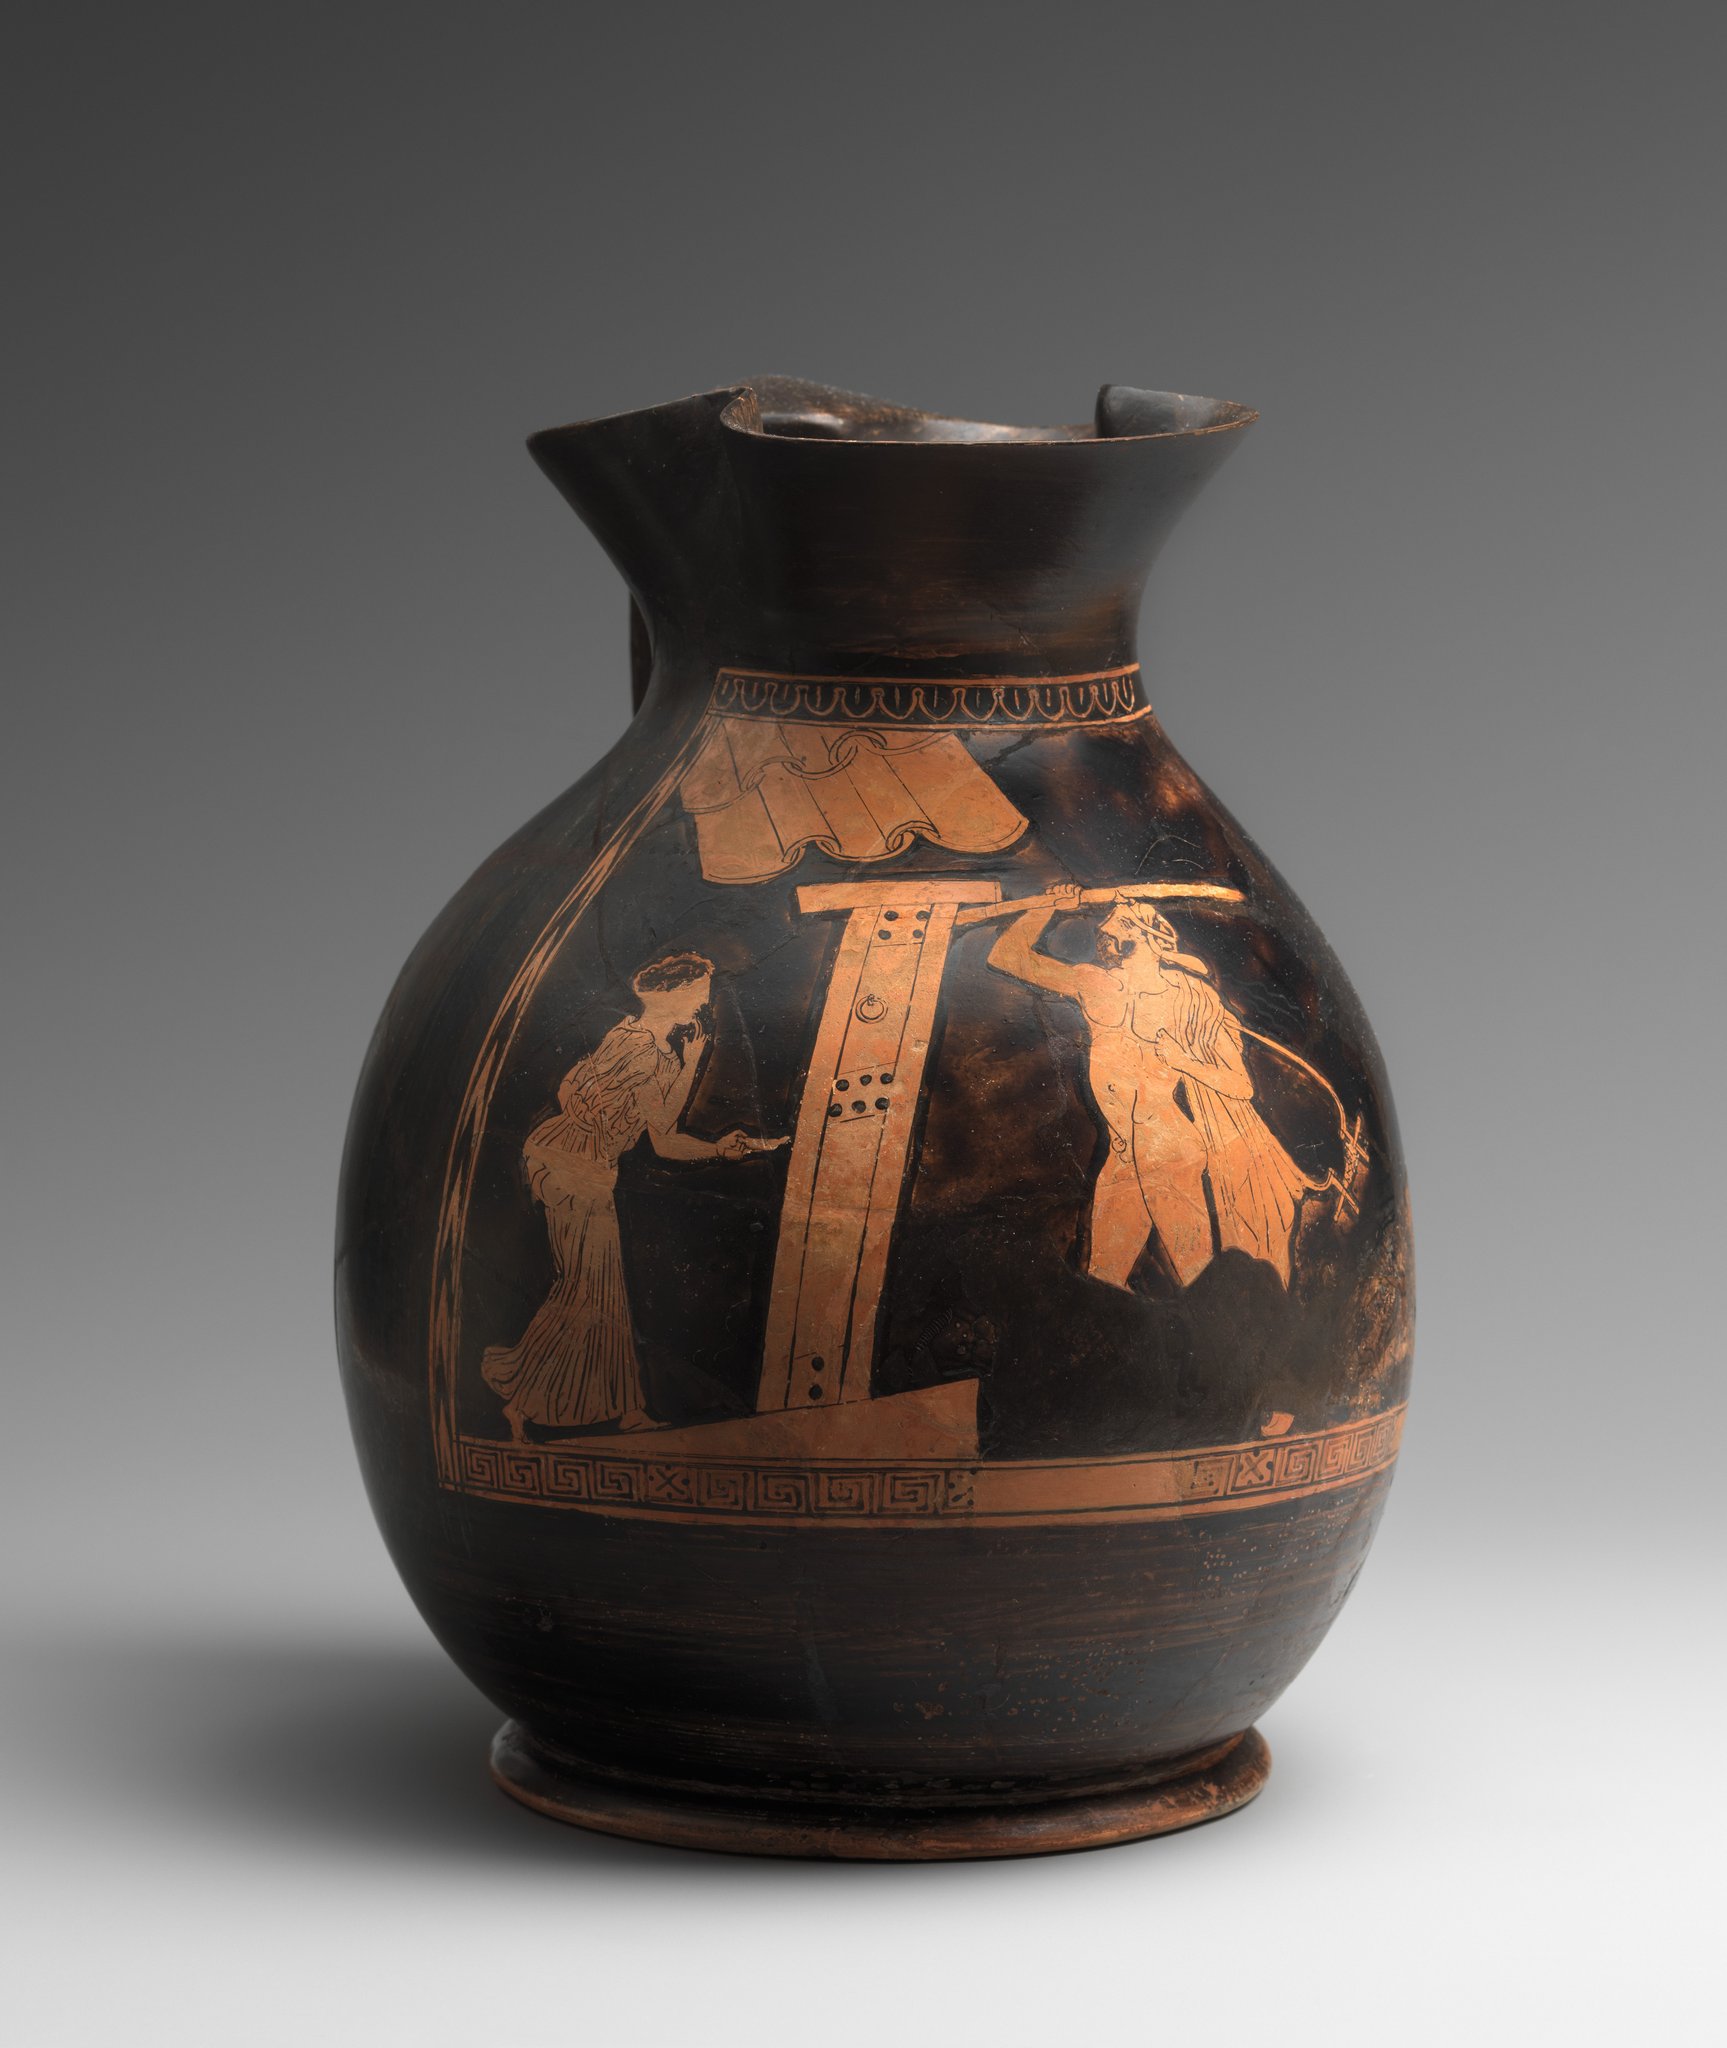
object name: oinochoe, chou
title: Terracotta oinochoe: chous (jug)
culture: greek, attic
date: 430-420 BCE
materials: terracotta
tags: doors,male nudes,women,lyres